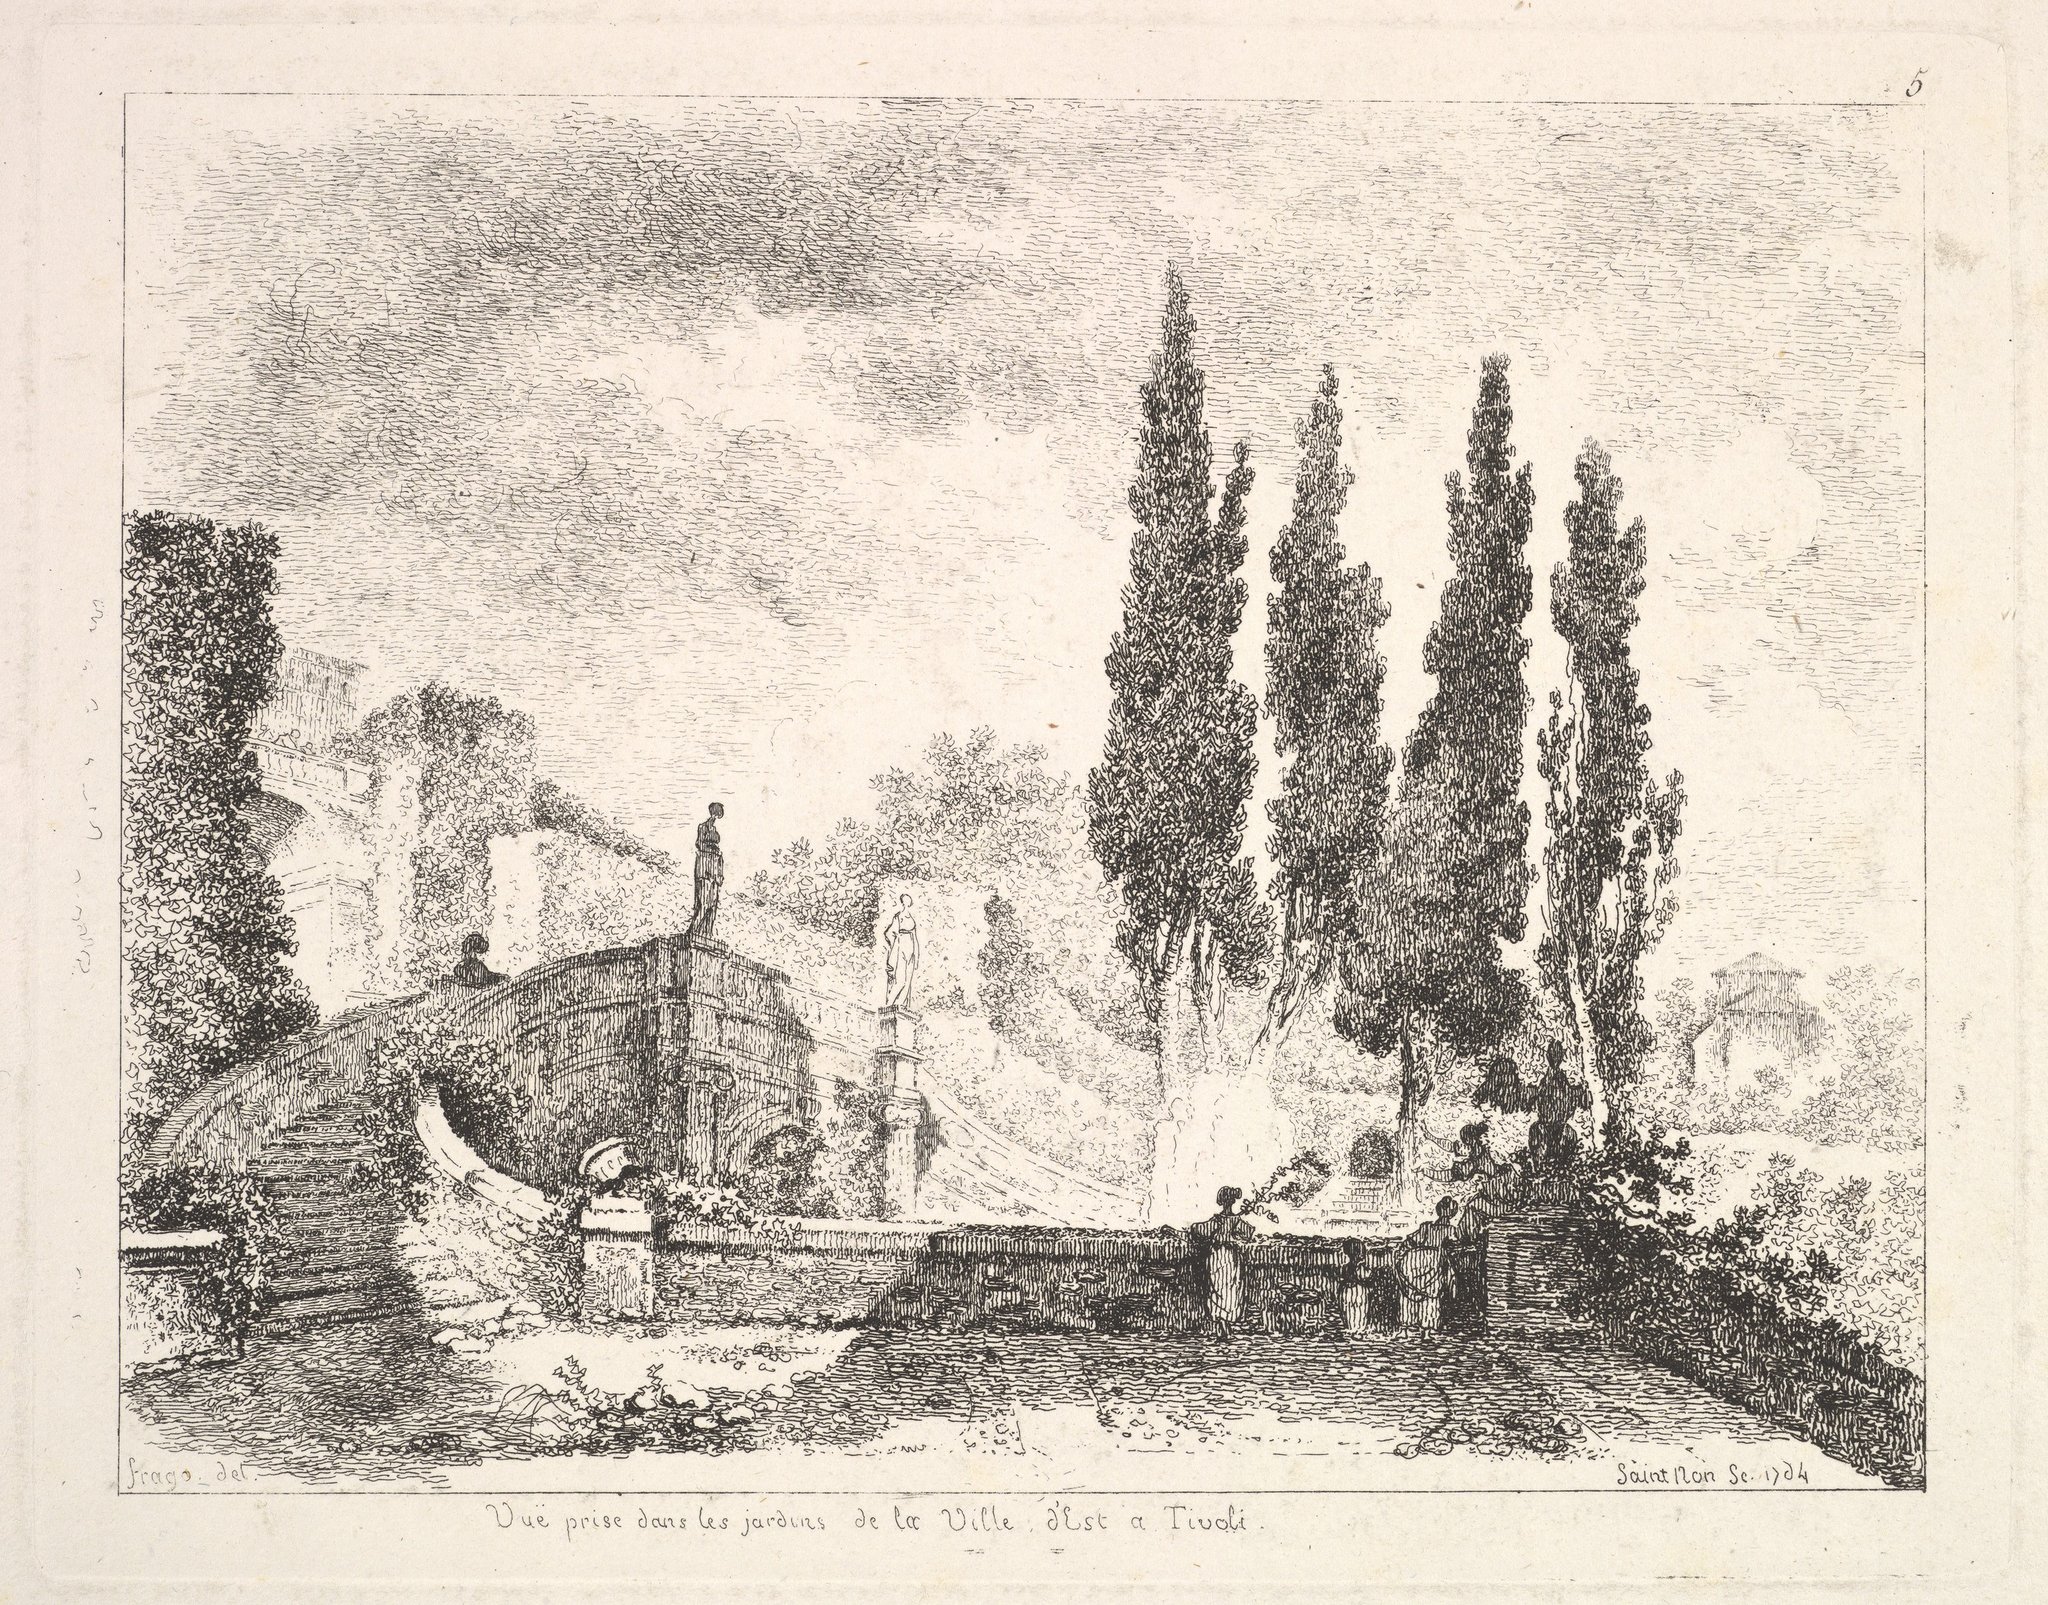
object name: print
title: View of the gardens at the Villa d'Este in Tivoli, cyprus trees to right, a staircase leading to the villa at left, two statues at center of the staircase, three figures in the garden at right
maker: jean honoré fragonard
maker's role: artist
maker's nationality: french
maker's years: 1732-1806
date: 1764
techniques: etching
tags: gardens,cypresses